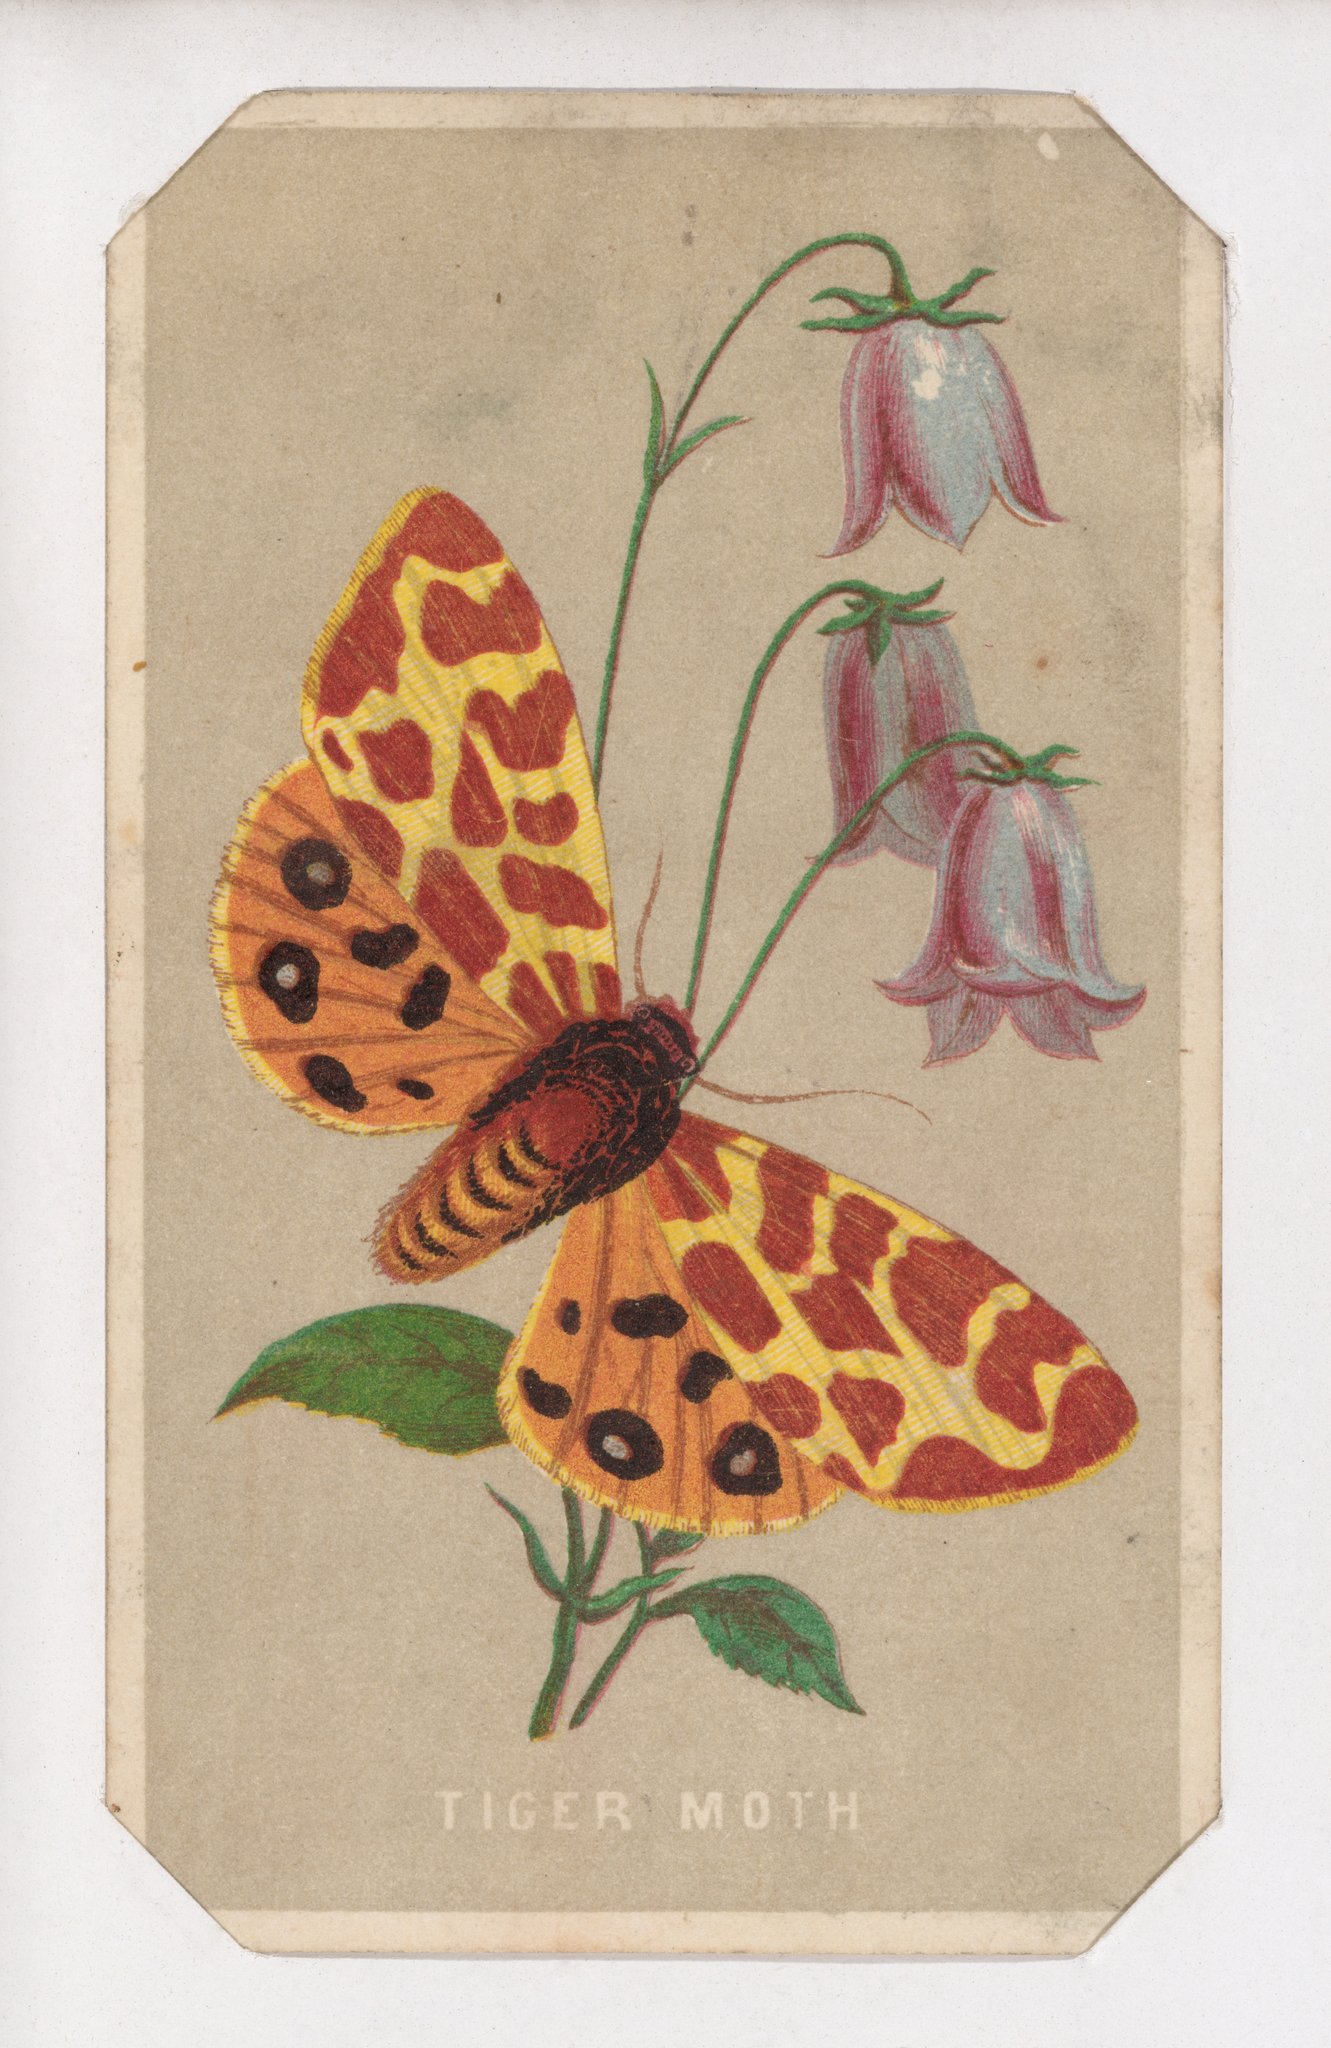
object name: album card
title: Tiger Moth card from the Butterflies and Moths of America series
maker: louis prang & co.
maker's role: publisher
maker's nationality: american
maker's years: 1800-1950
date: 1862-1869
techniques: lithograph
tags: butterflies